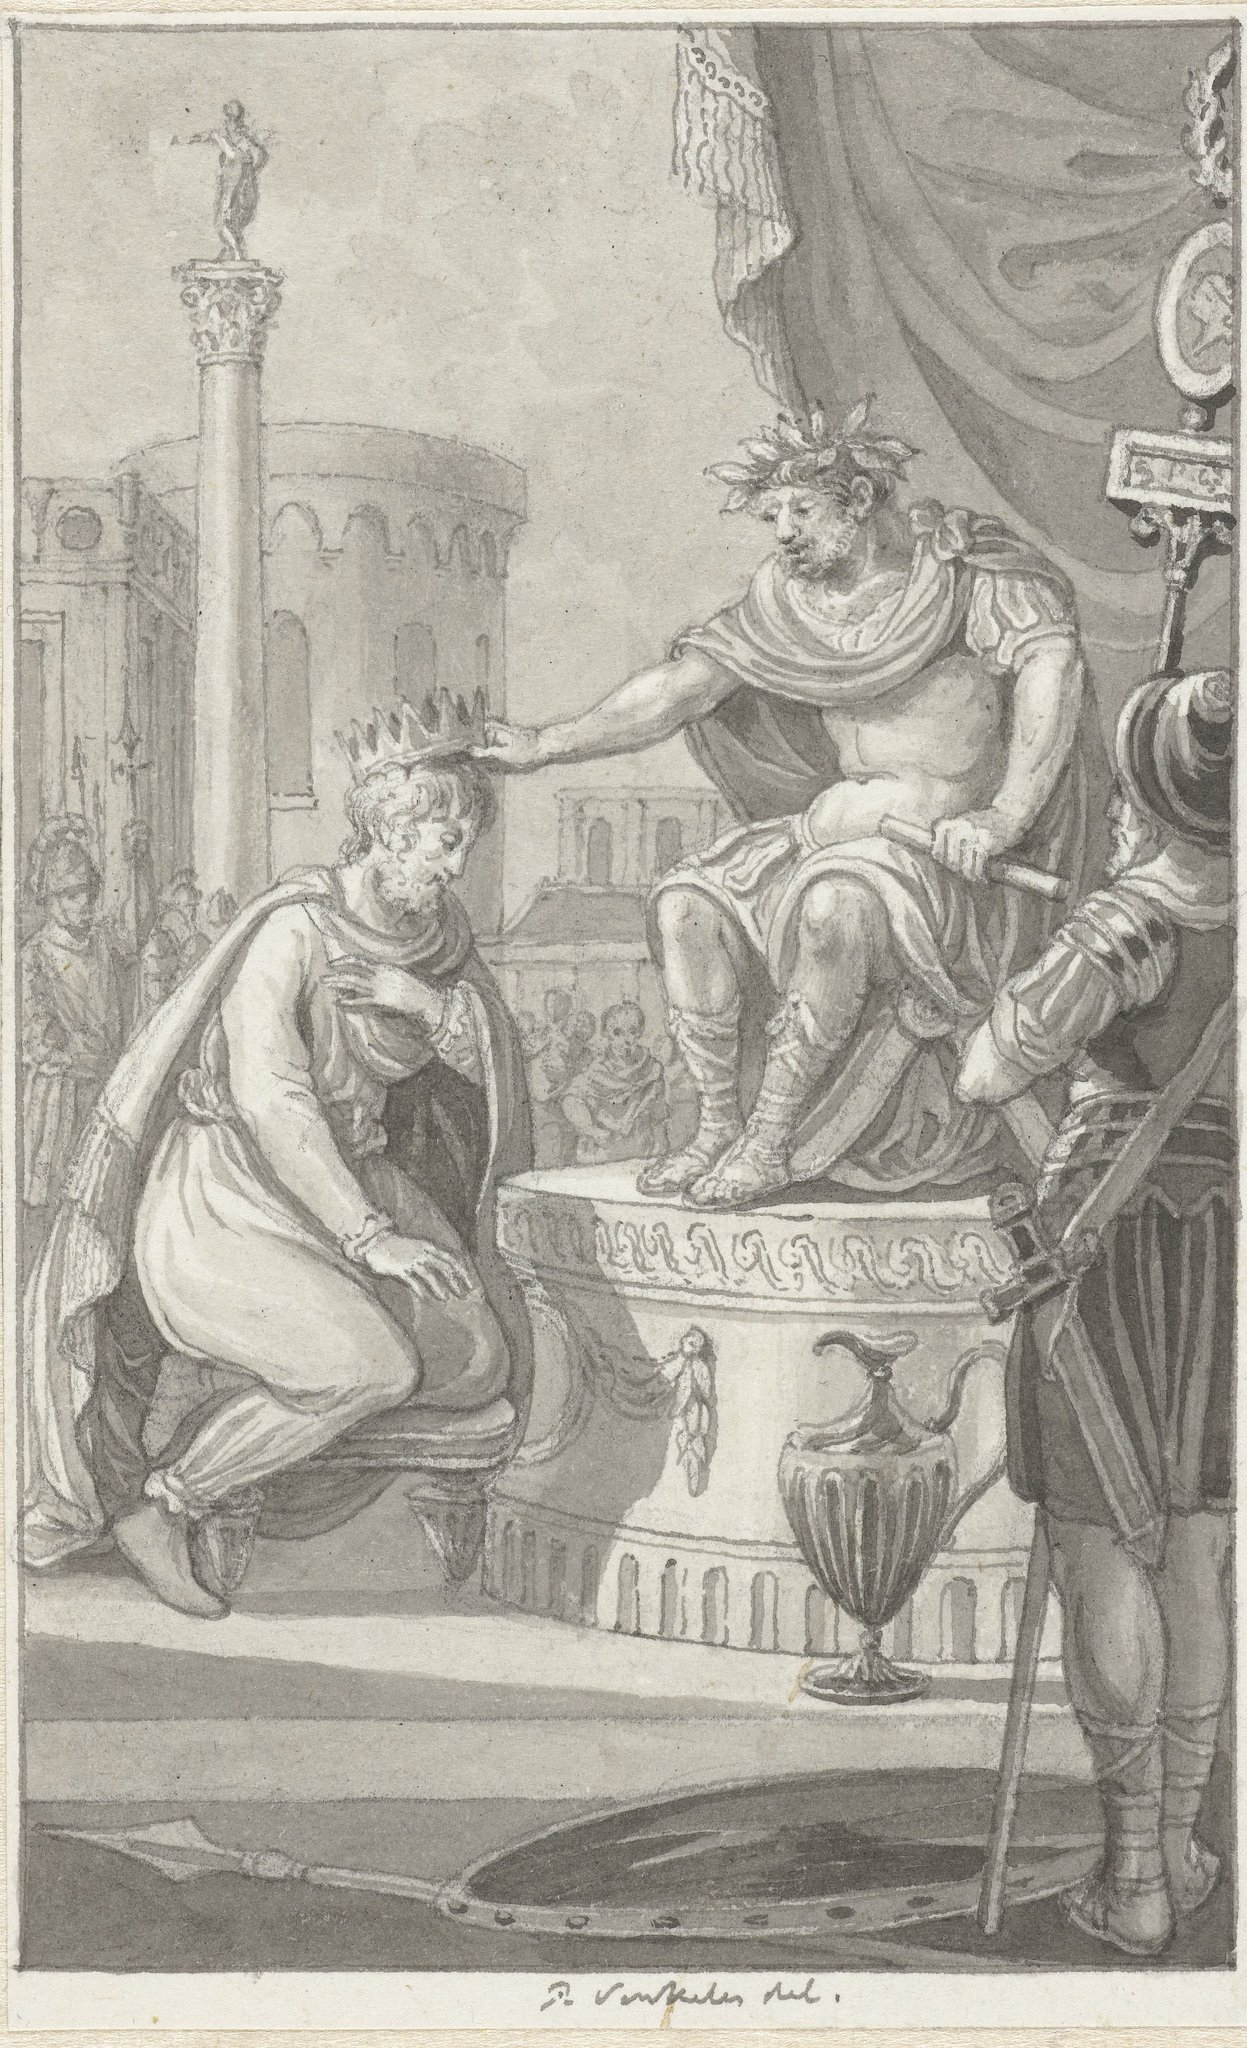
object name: drawing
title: Nero's hoogmoed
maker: reinier vinkeles (i)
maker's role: draughtsman, print maker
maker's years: 1741-1816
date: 1804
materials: ink, paper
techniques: brush, pen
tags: non-aggressive activities of nero, coronation of a ruler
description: Ontwerp voor gravure door Ludwig Portman in M. Stuart's `Romeinsche Geschiedenissen', 1804, dl. 24 t.o. p. 238.